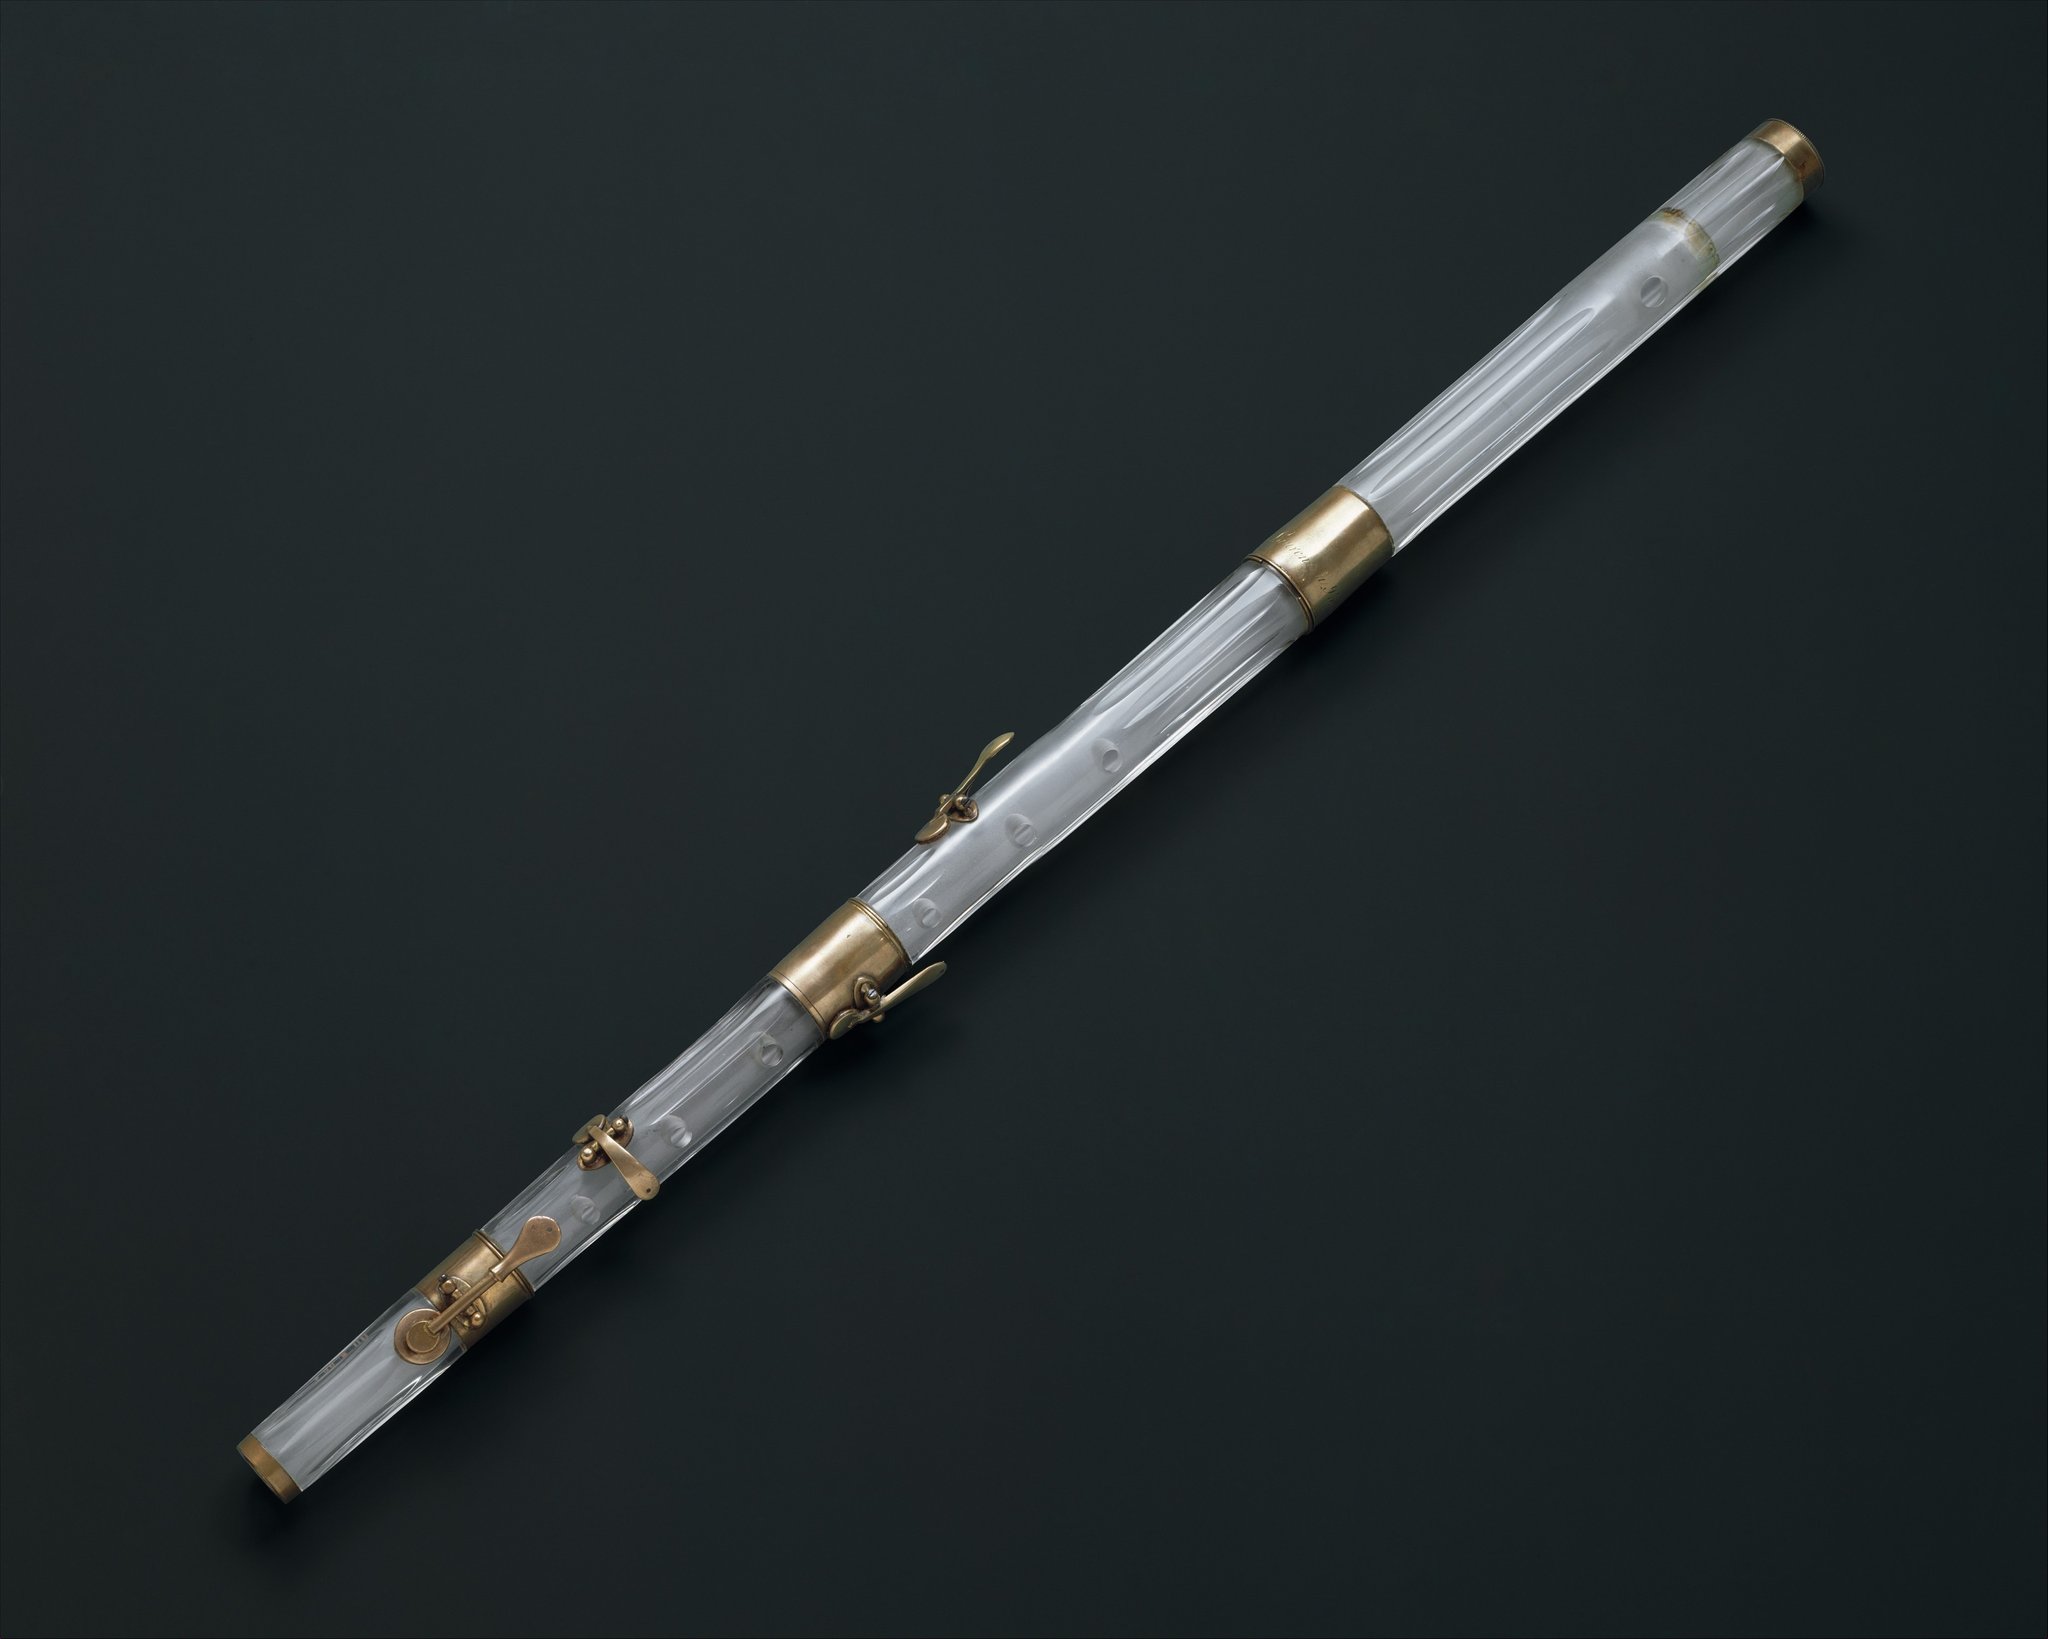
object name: transverse flute in d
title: Transverse Flute in D-flat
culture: french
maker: claude laurent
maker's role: maker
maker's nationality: french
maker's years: 1805-1848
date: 1813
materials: brass, glass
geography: france